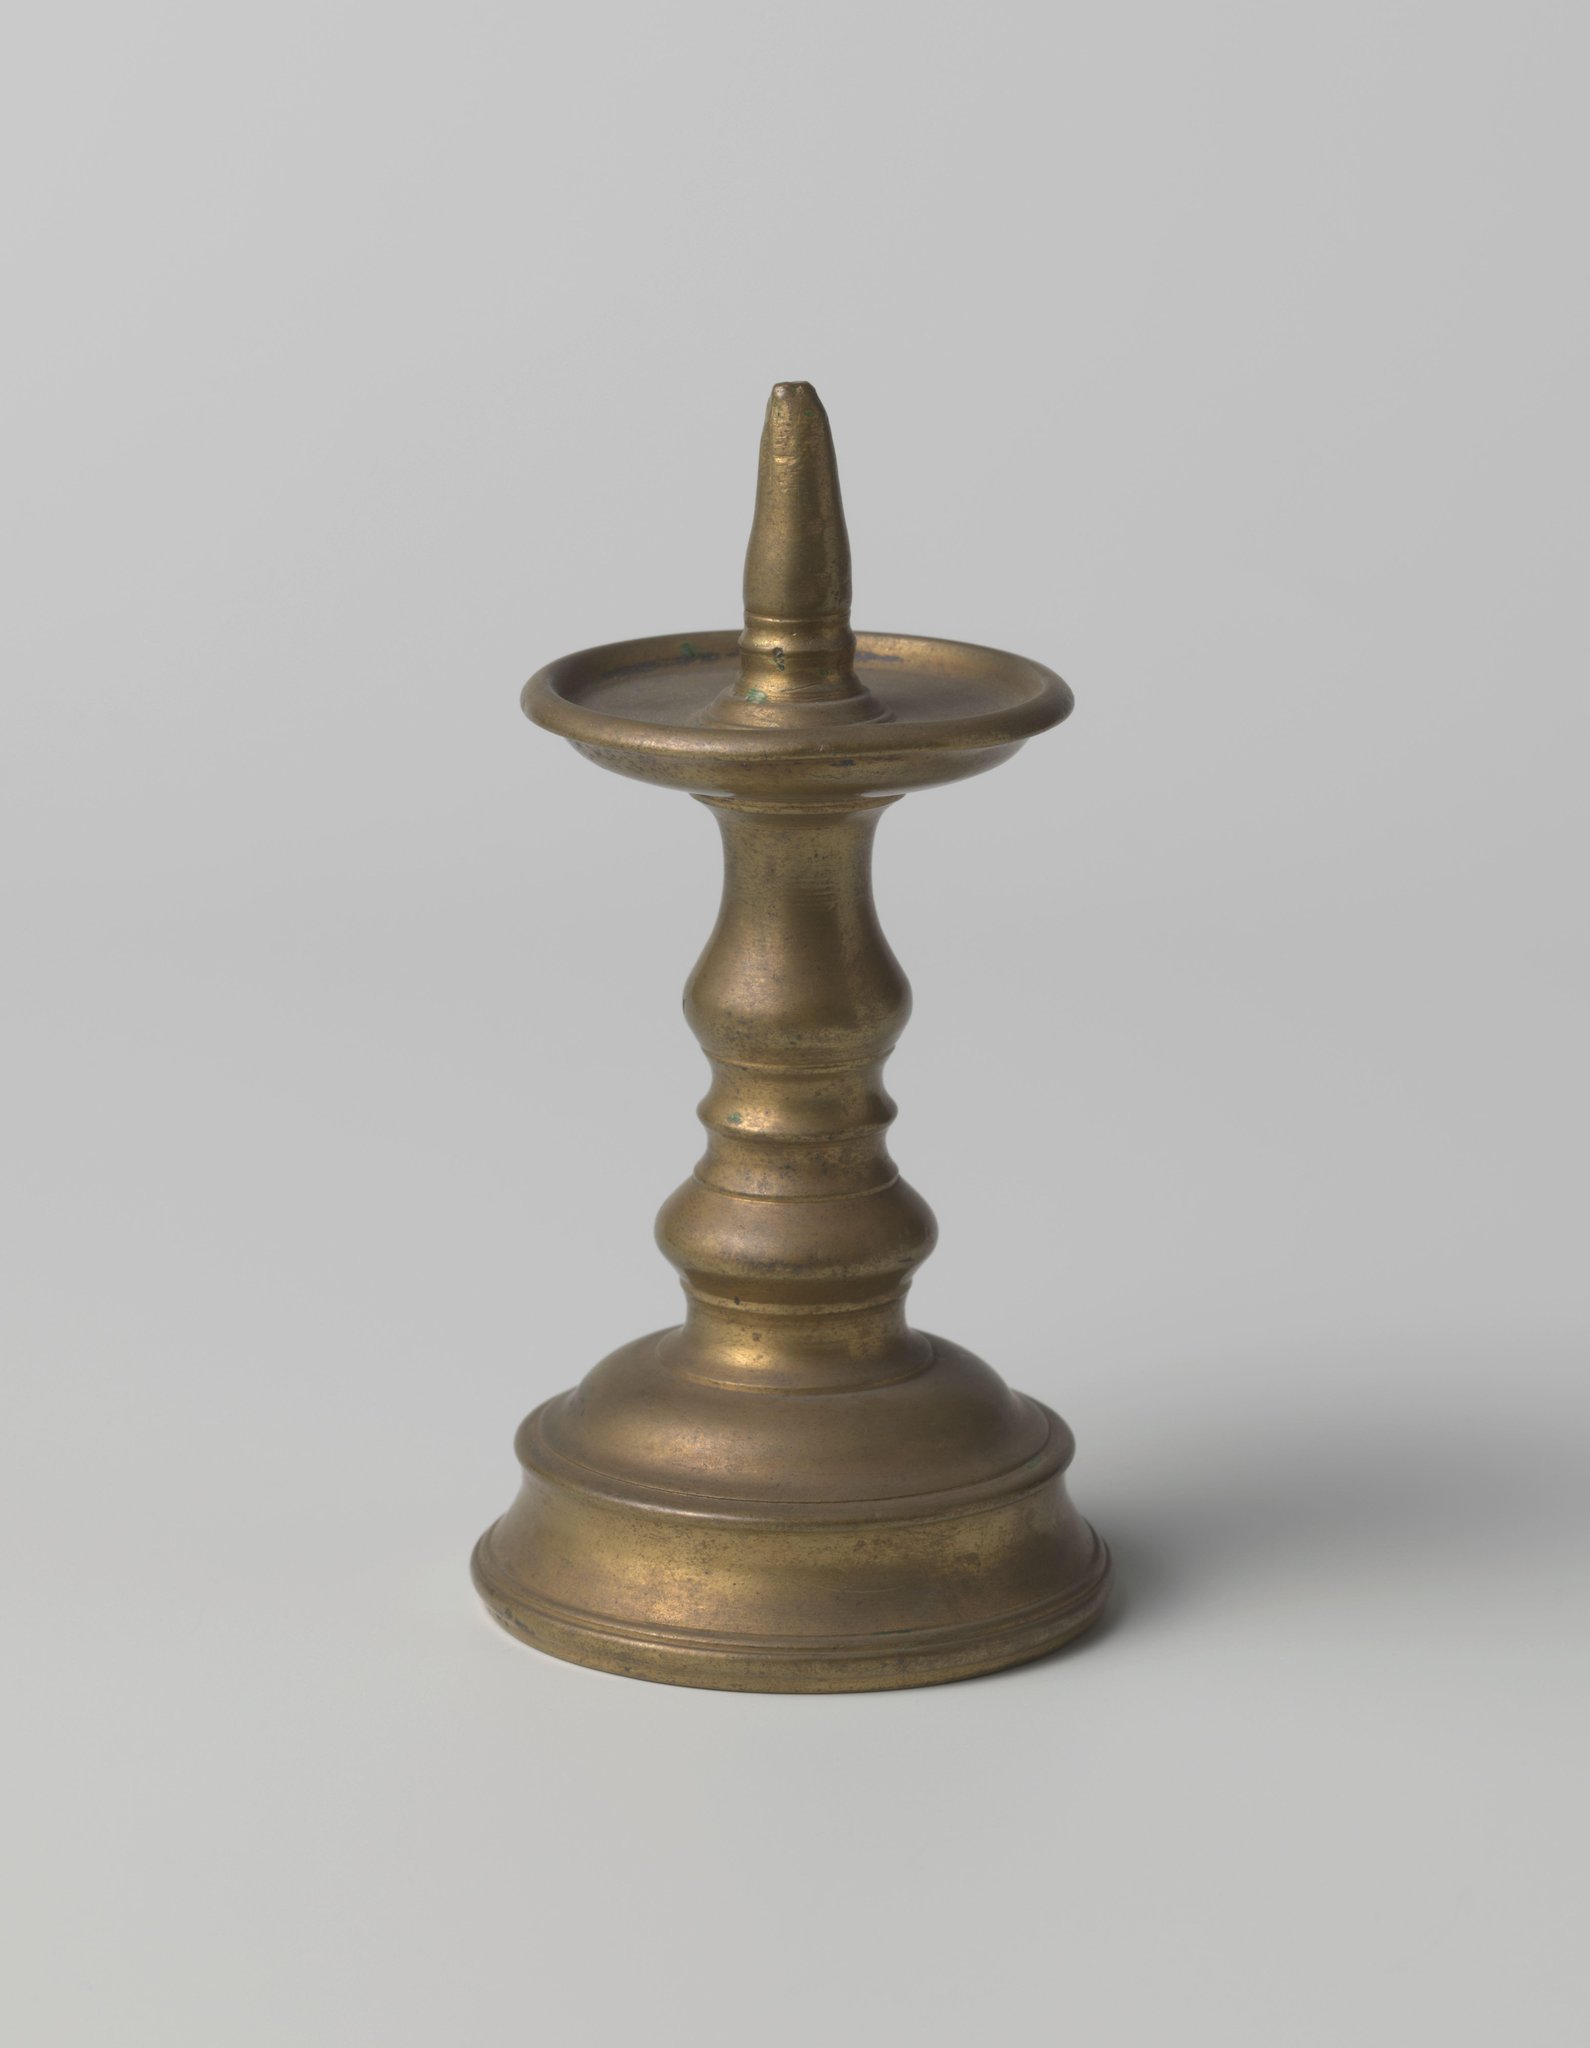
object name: candlestick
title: Kandelaar van messing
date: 1600-1700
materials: brass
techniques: casting, turning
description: Het voorwerp, dat in één geheel gegoten is, heeft een ronde voet, een enigszins bol- en balustervormig geprofileerde stam, een ronde vetvanger en een bij de aanzet geprofileerde kaarsenpin. Binnenin wordt de ronde holle stam gemarkeerd door vier groeven op onderling gelijke afstand, dienende om de draaibank houvast te verschaffen. Het object vertoont kleine verschillen met kandelaar BK-NM-2289-B.